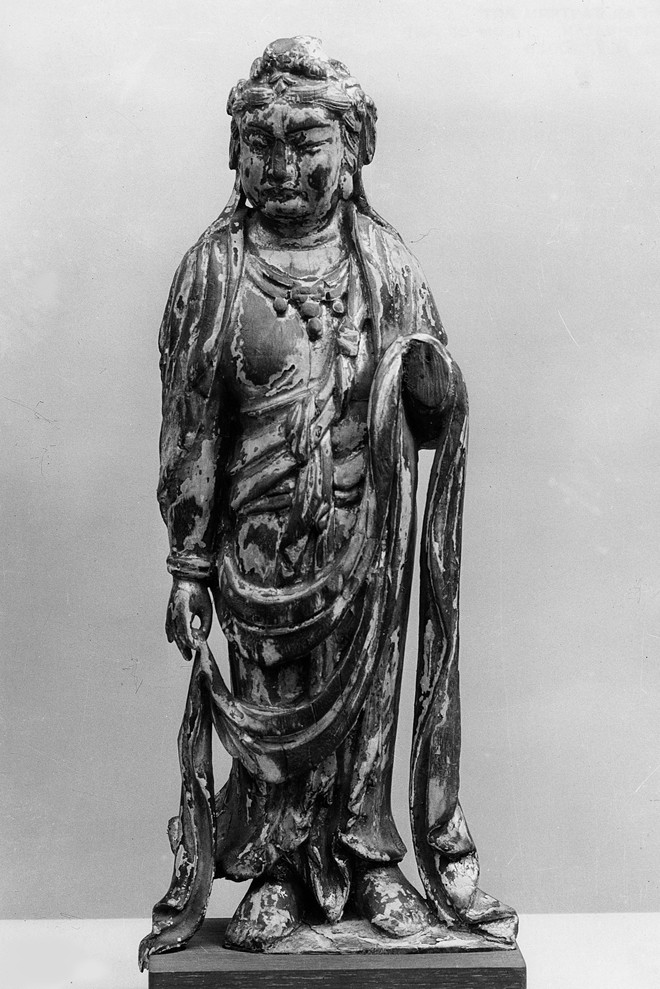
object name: figure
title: Standing Bodhisattva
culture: chinese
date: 960-1279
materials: gilt, wood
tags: bodhisattvas